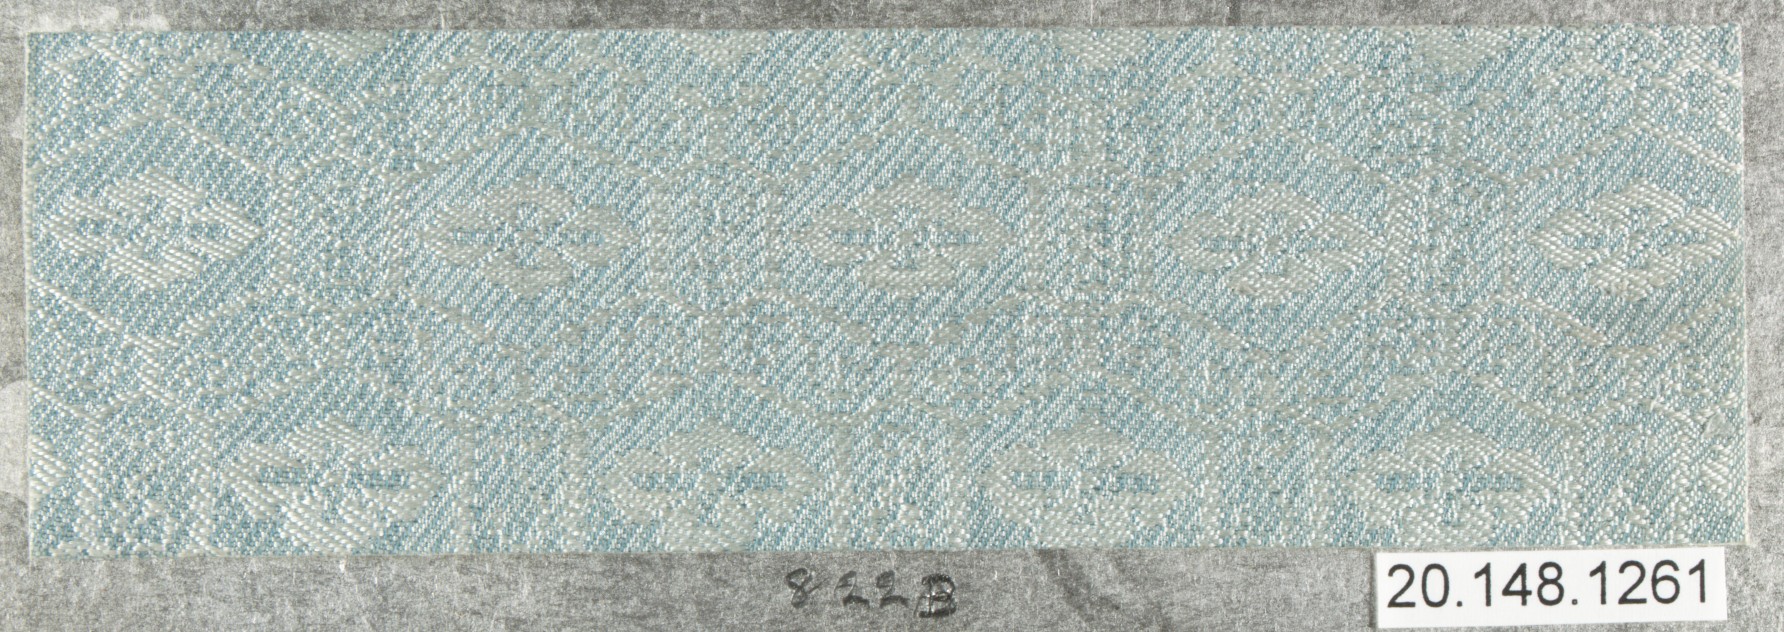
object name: piece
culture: japanese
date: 1701-1800